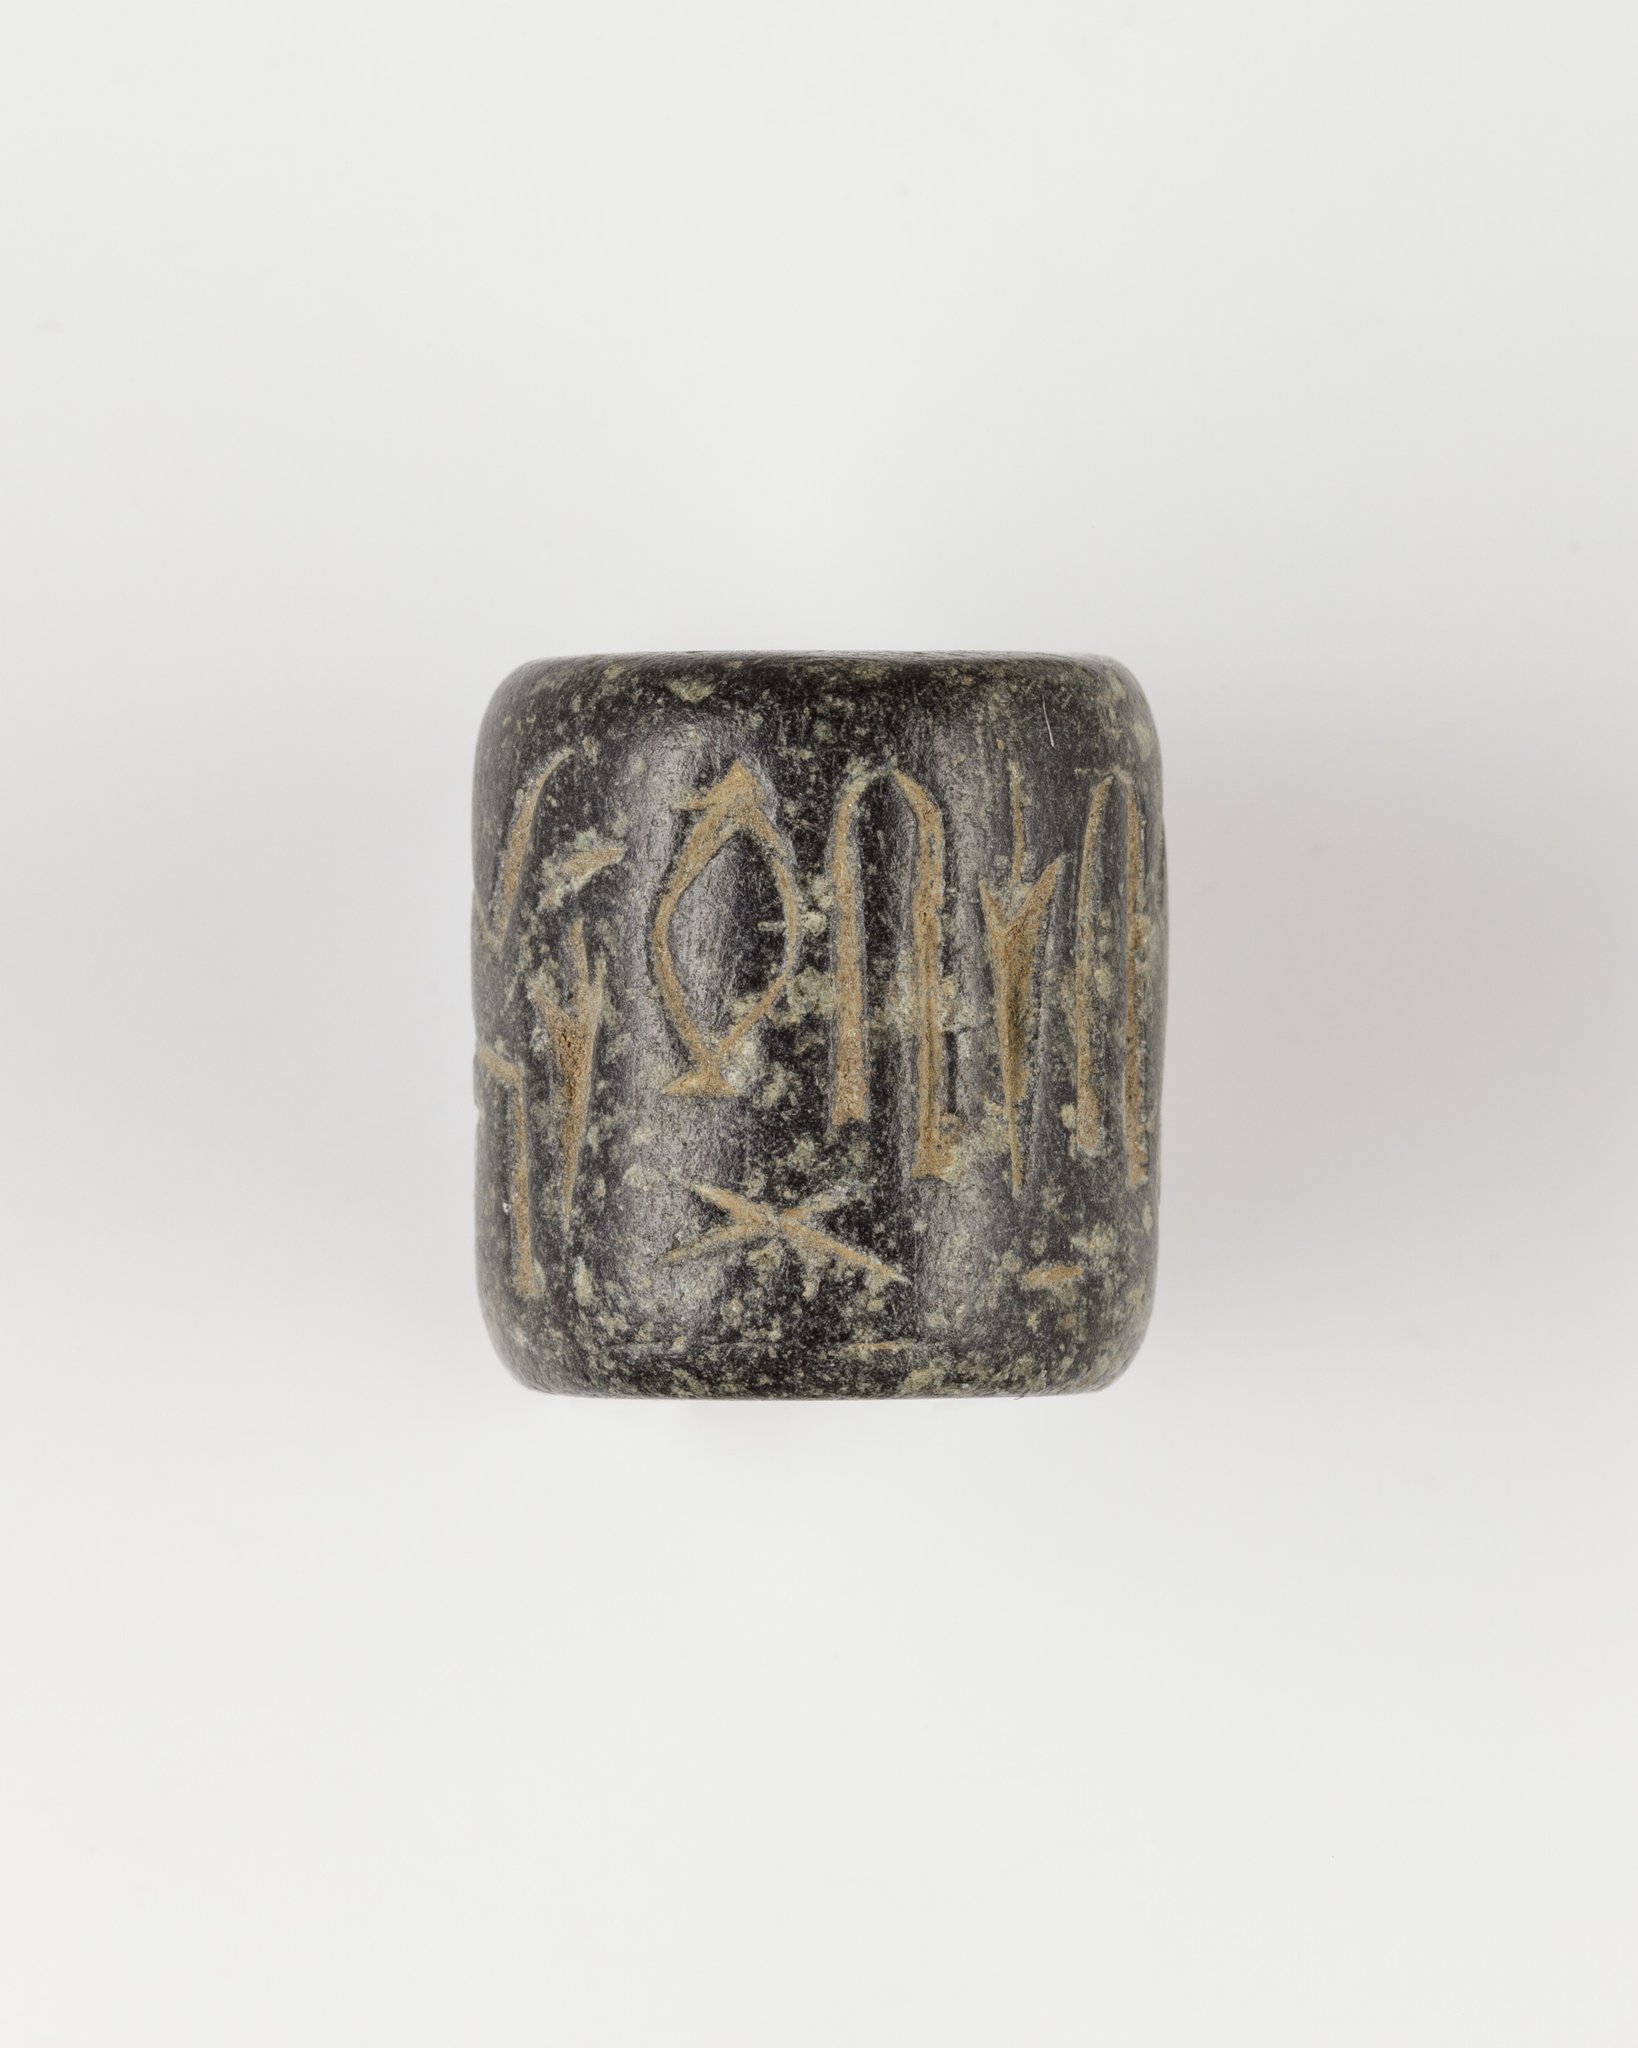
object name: cylinder seal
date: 2960-2770 BCE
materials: stone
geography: egypt